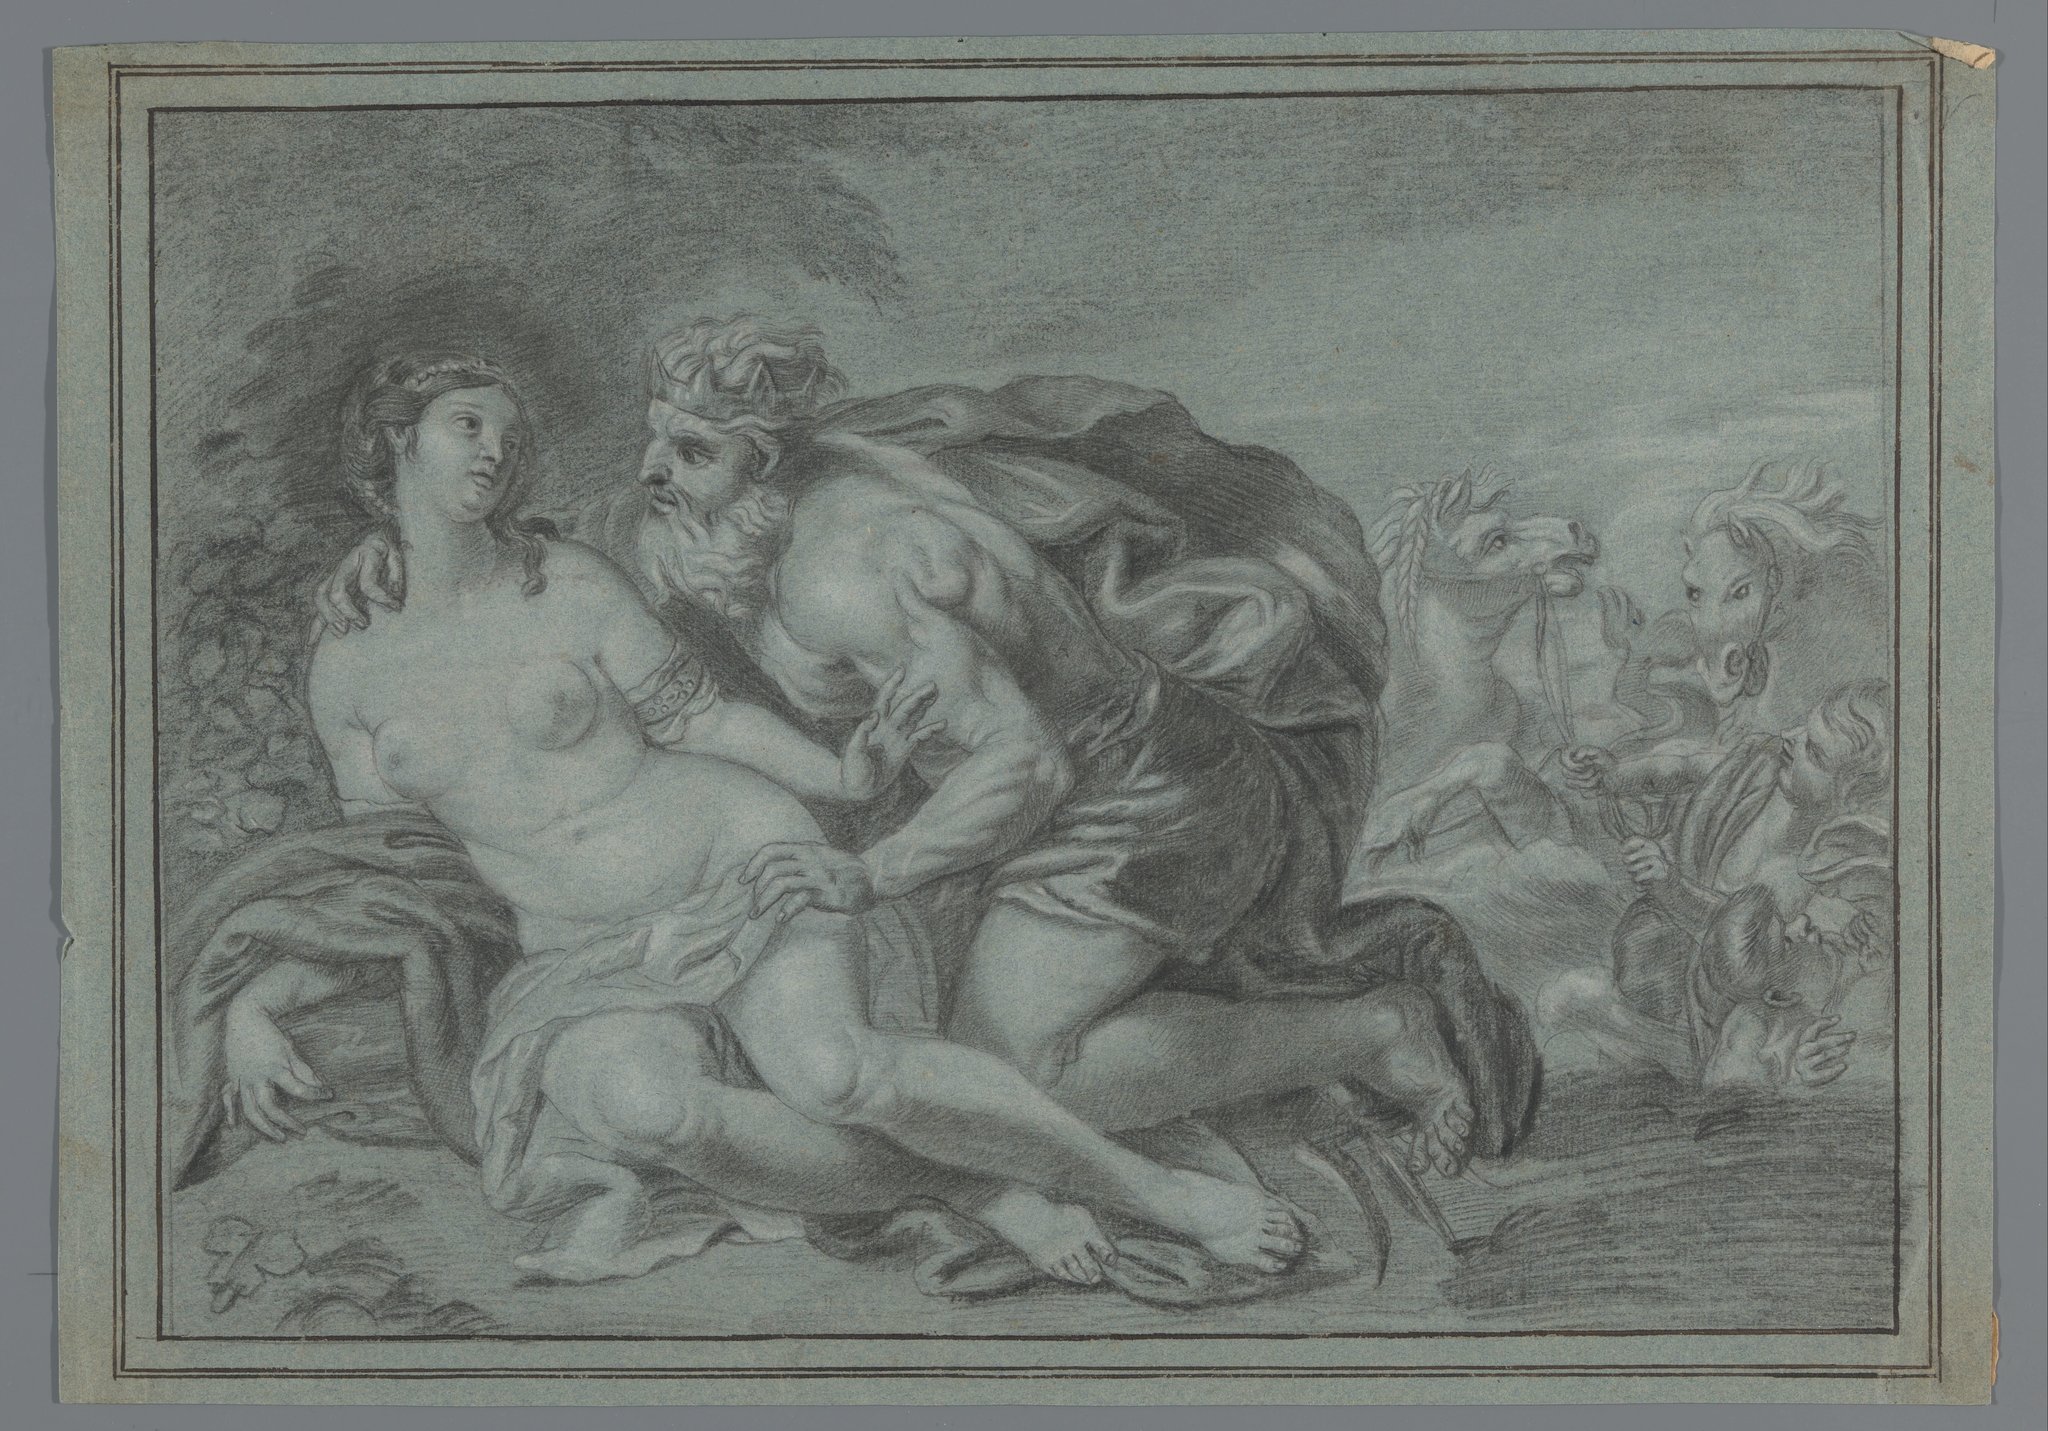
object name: drawing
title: Neptunus met een nimf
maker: Anonymous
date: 1700-1800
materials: chalk, paper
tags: love-affairs of neptune: first series